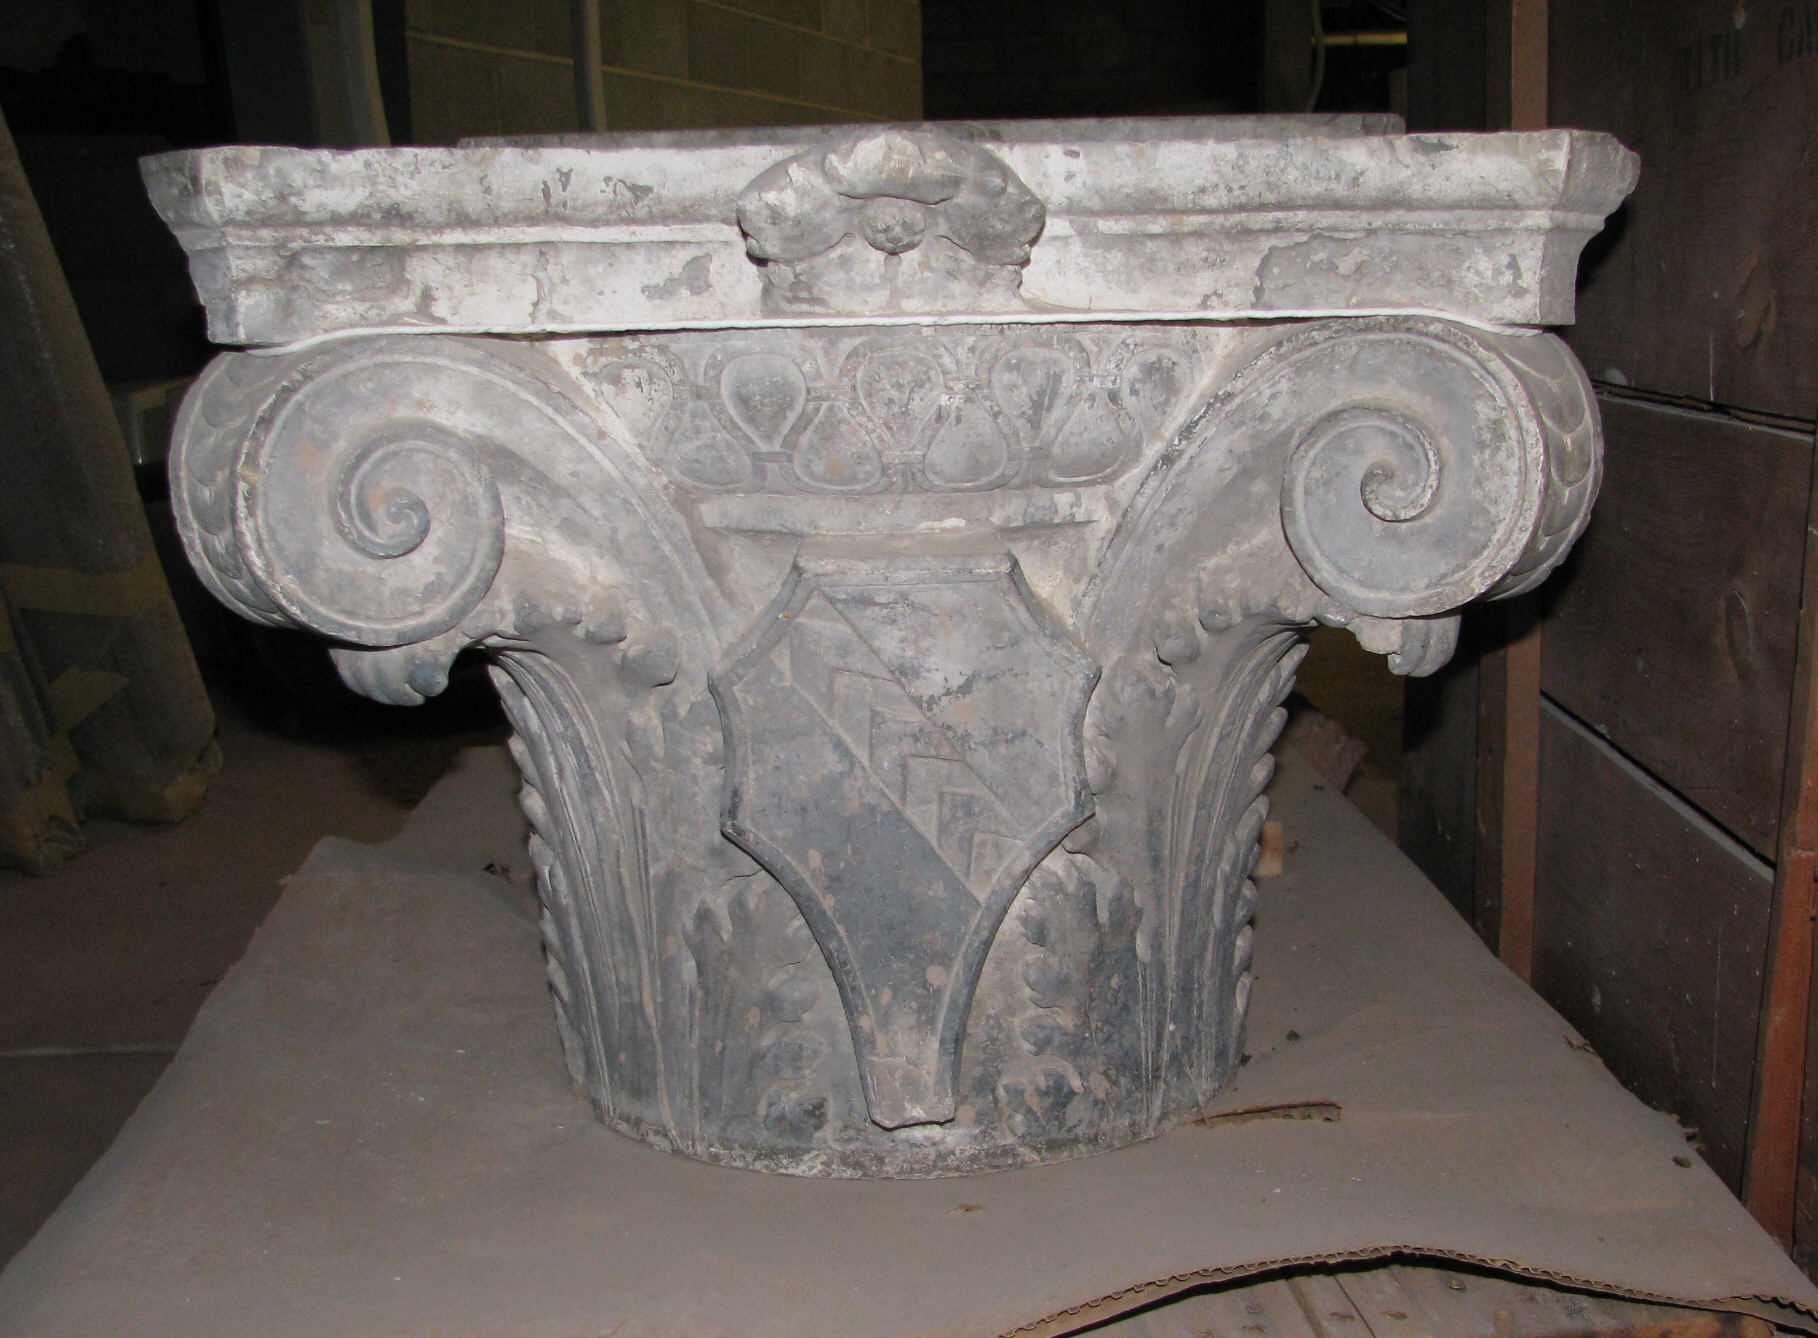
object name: capital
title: Capital (one of a series)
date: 1451-1500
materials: stone